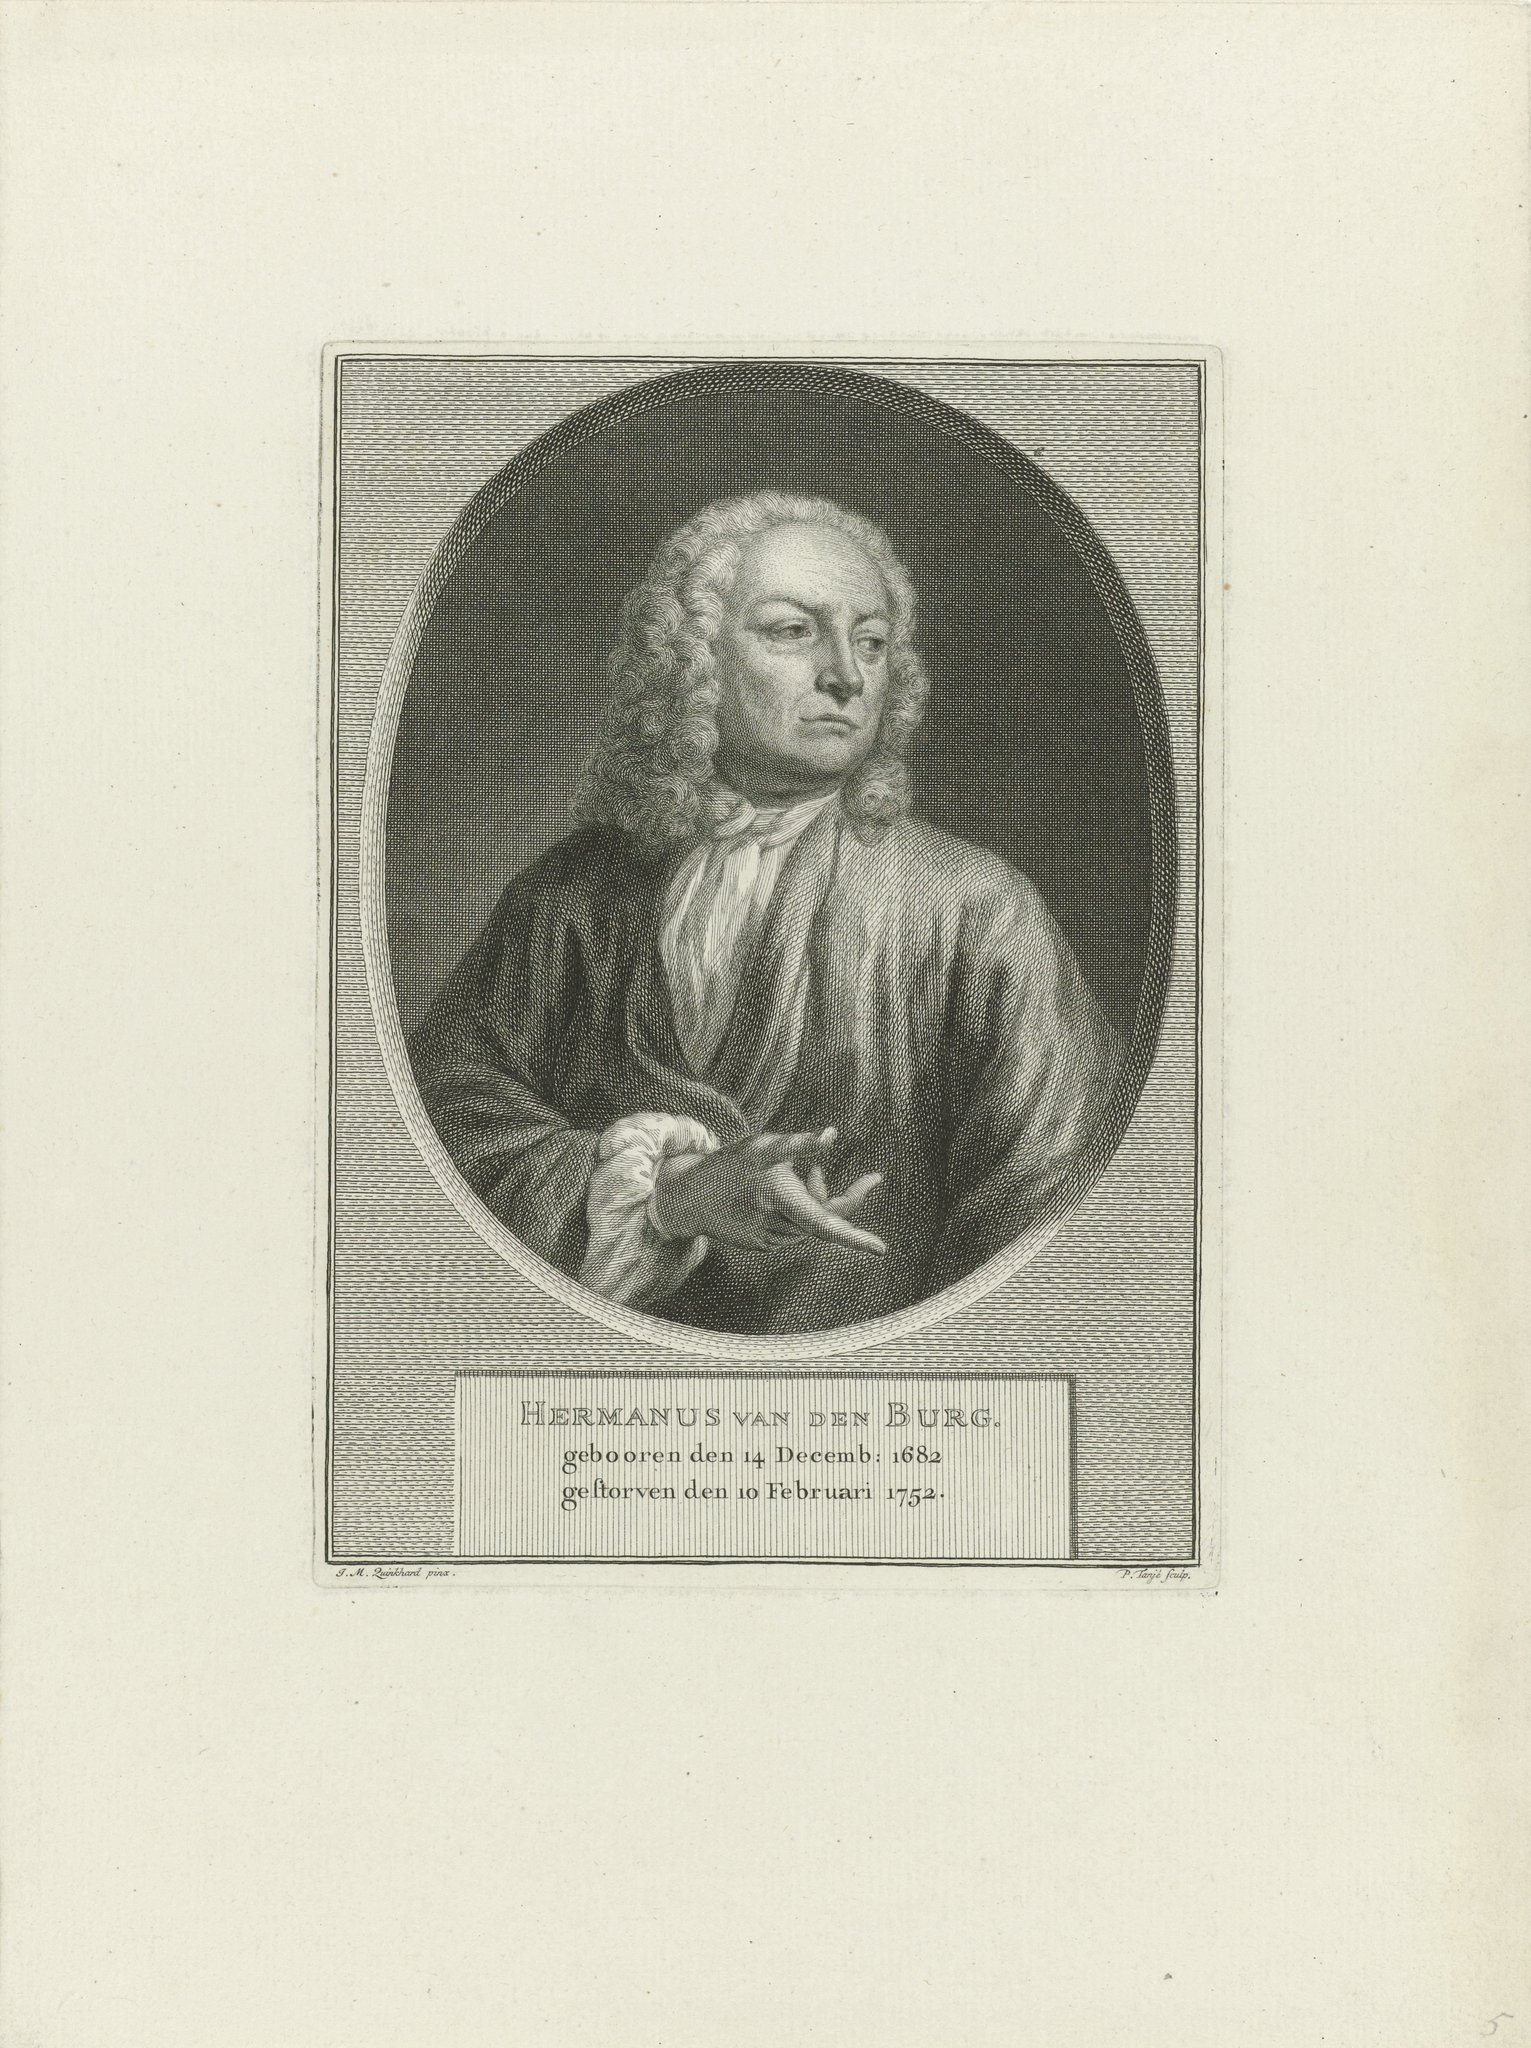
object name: print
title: Portret van Hermanus van den Burg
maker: pieter tanjé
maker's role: draughtsman, print maker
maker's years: 1706-1761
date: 1752-1754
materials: paper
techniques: engraving, etching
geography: amsterdam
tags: amsterdam, hermanus van den burg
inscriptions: collector's mark: Lugt 240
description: Portret van Hermanus van den Burg, gelegenheidsdichter en toneelschrijver te Amsterdam.